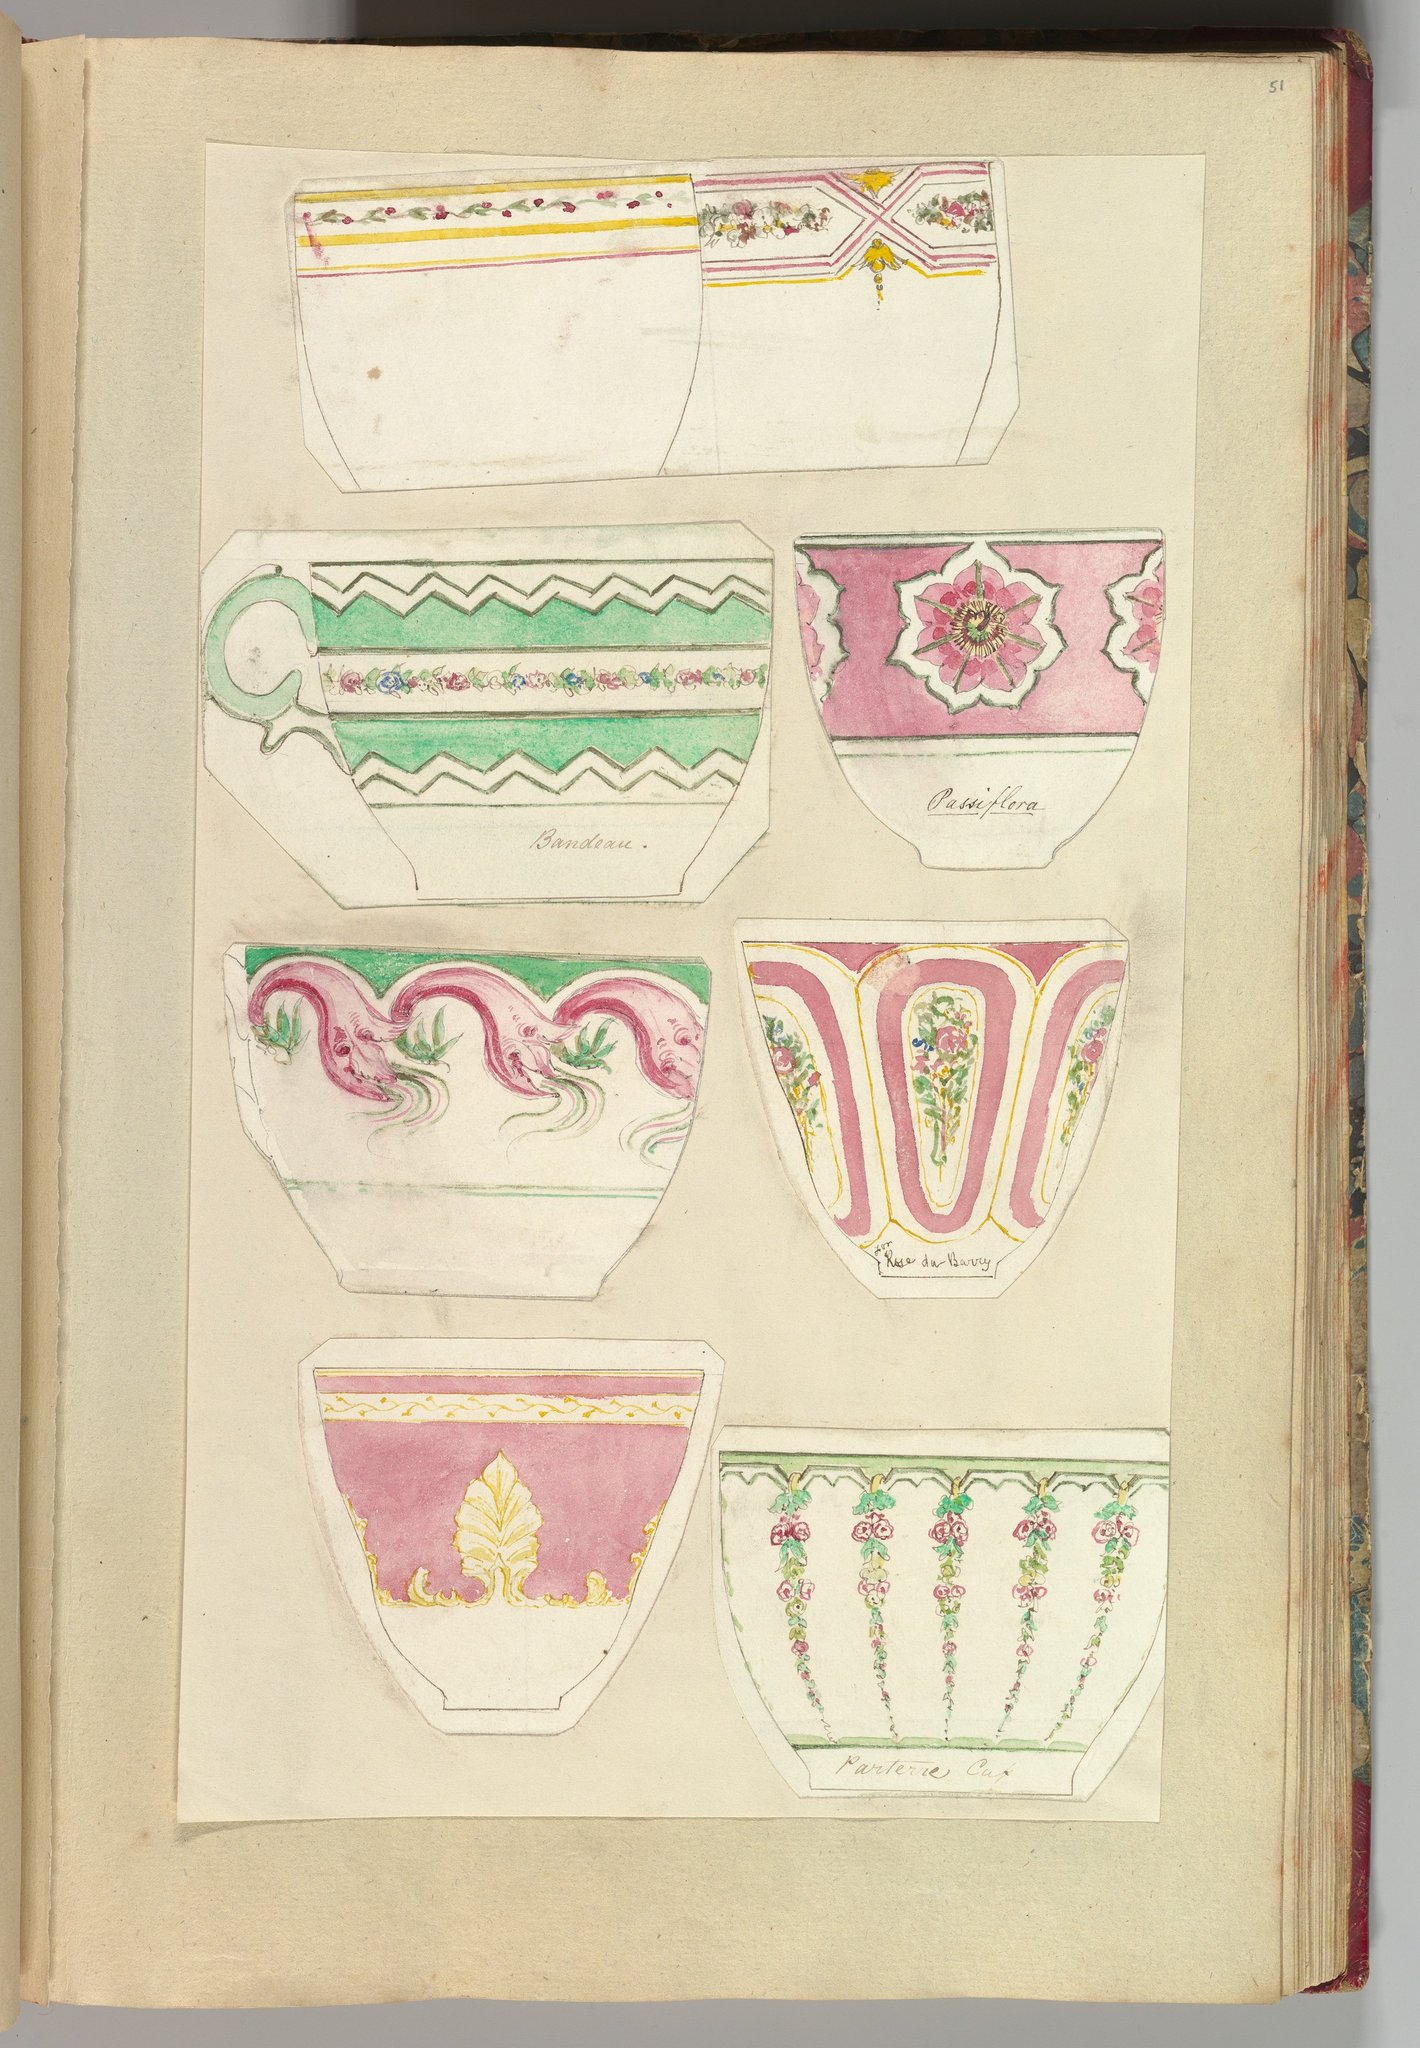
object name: drawing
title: Eight Designs for Decorated Cups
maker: alfred henry forrester [alfred crowquill]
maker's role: artist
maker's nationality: british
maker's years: 1804-1872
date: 1845-1855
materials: ink, watercolor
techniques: pen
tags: cups